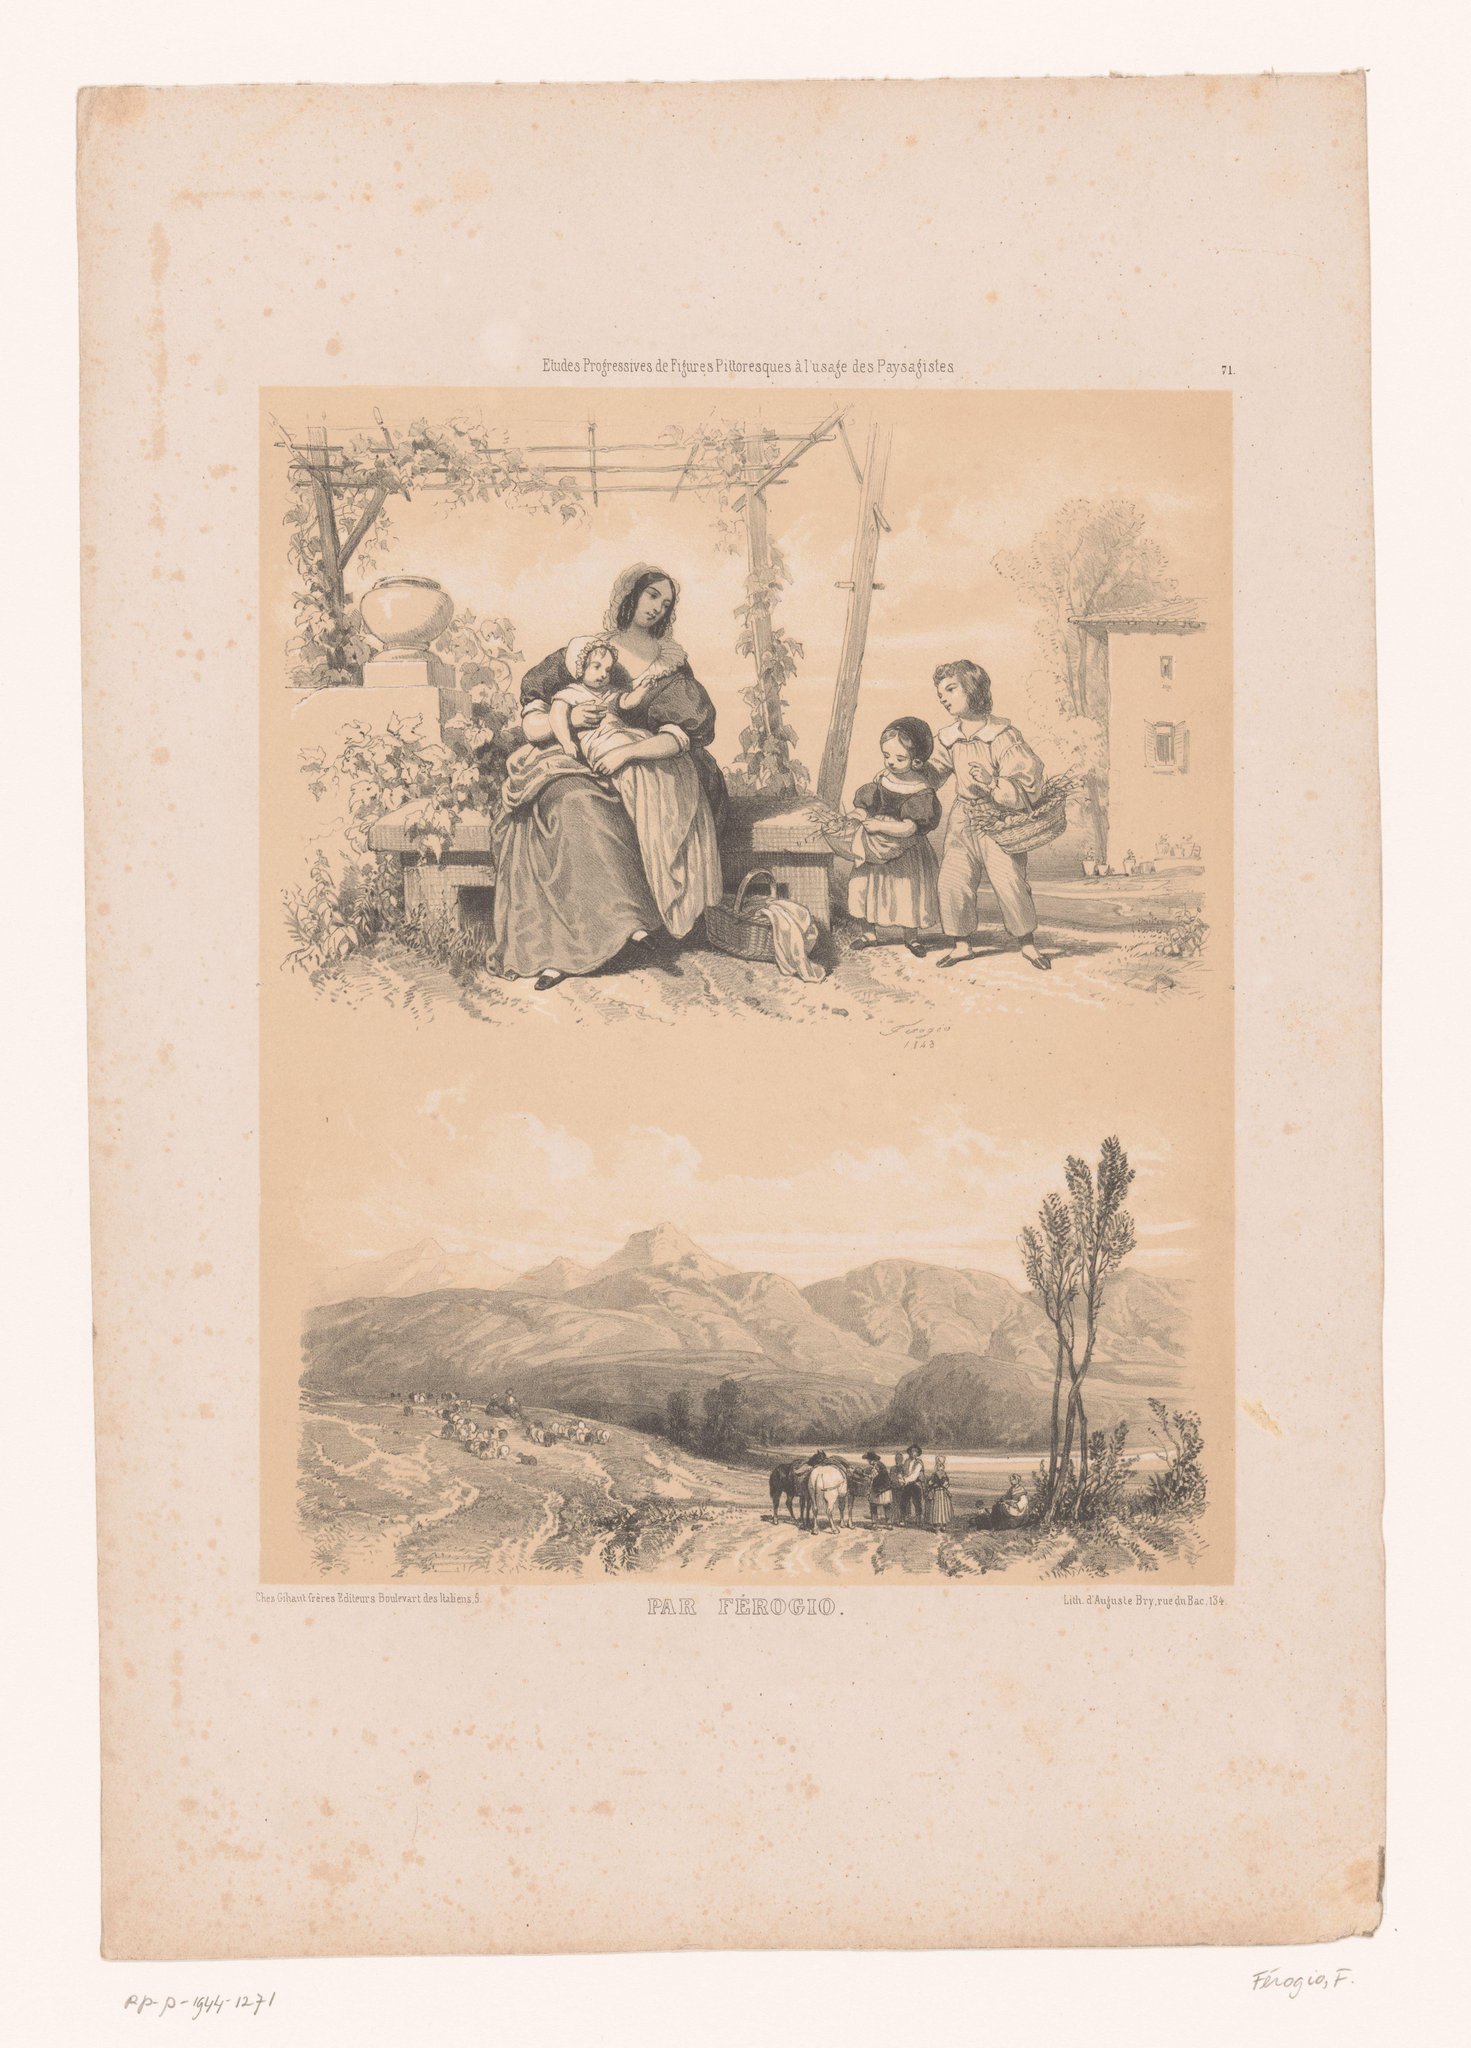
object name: print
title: Etudes Progressives de Figures Pittoresques à l'usage des Paysagistes, par Férogio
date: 1843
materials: paper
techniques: tone lithography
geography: paris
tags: country dwellers, mountains (+ landscape with figures, staffage), mother and child(ren), woman and child(ren) (family group) (with number of children)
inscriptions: collector's mark: Lugt 2228a